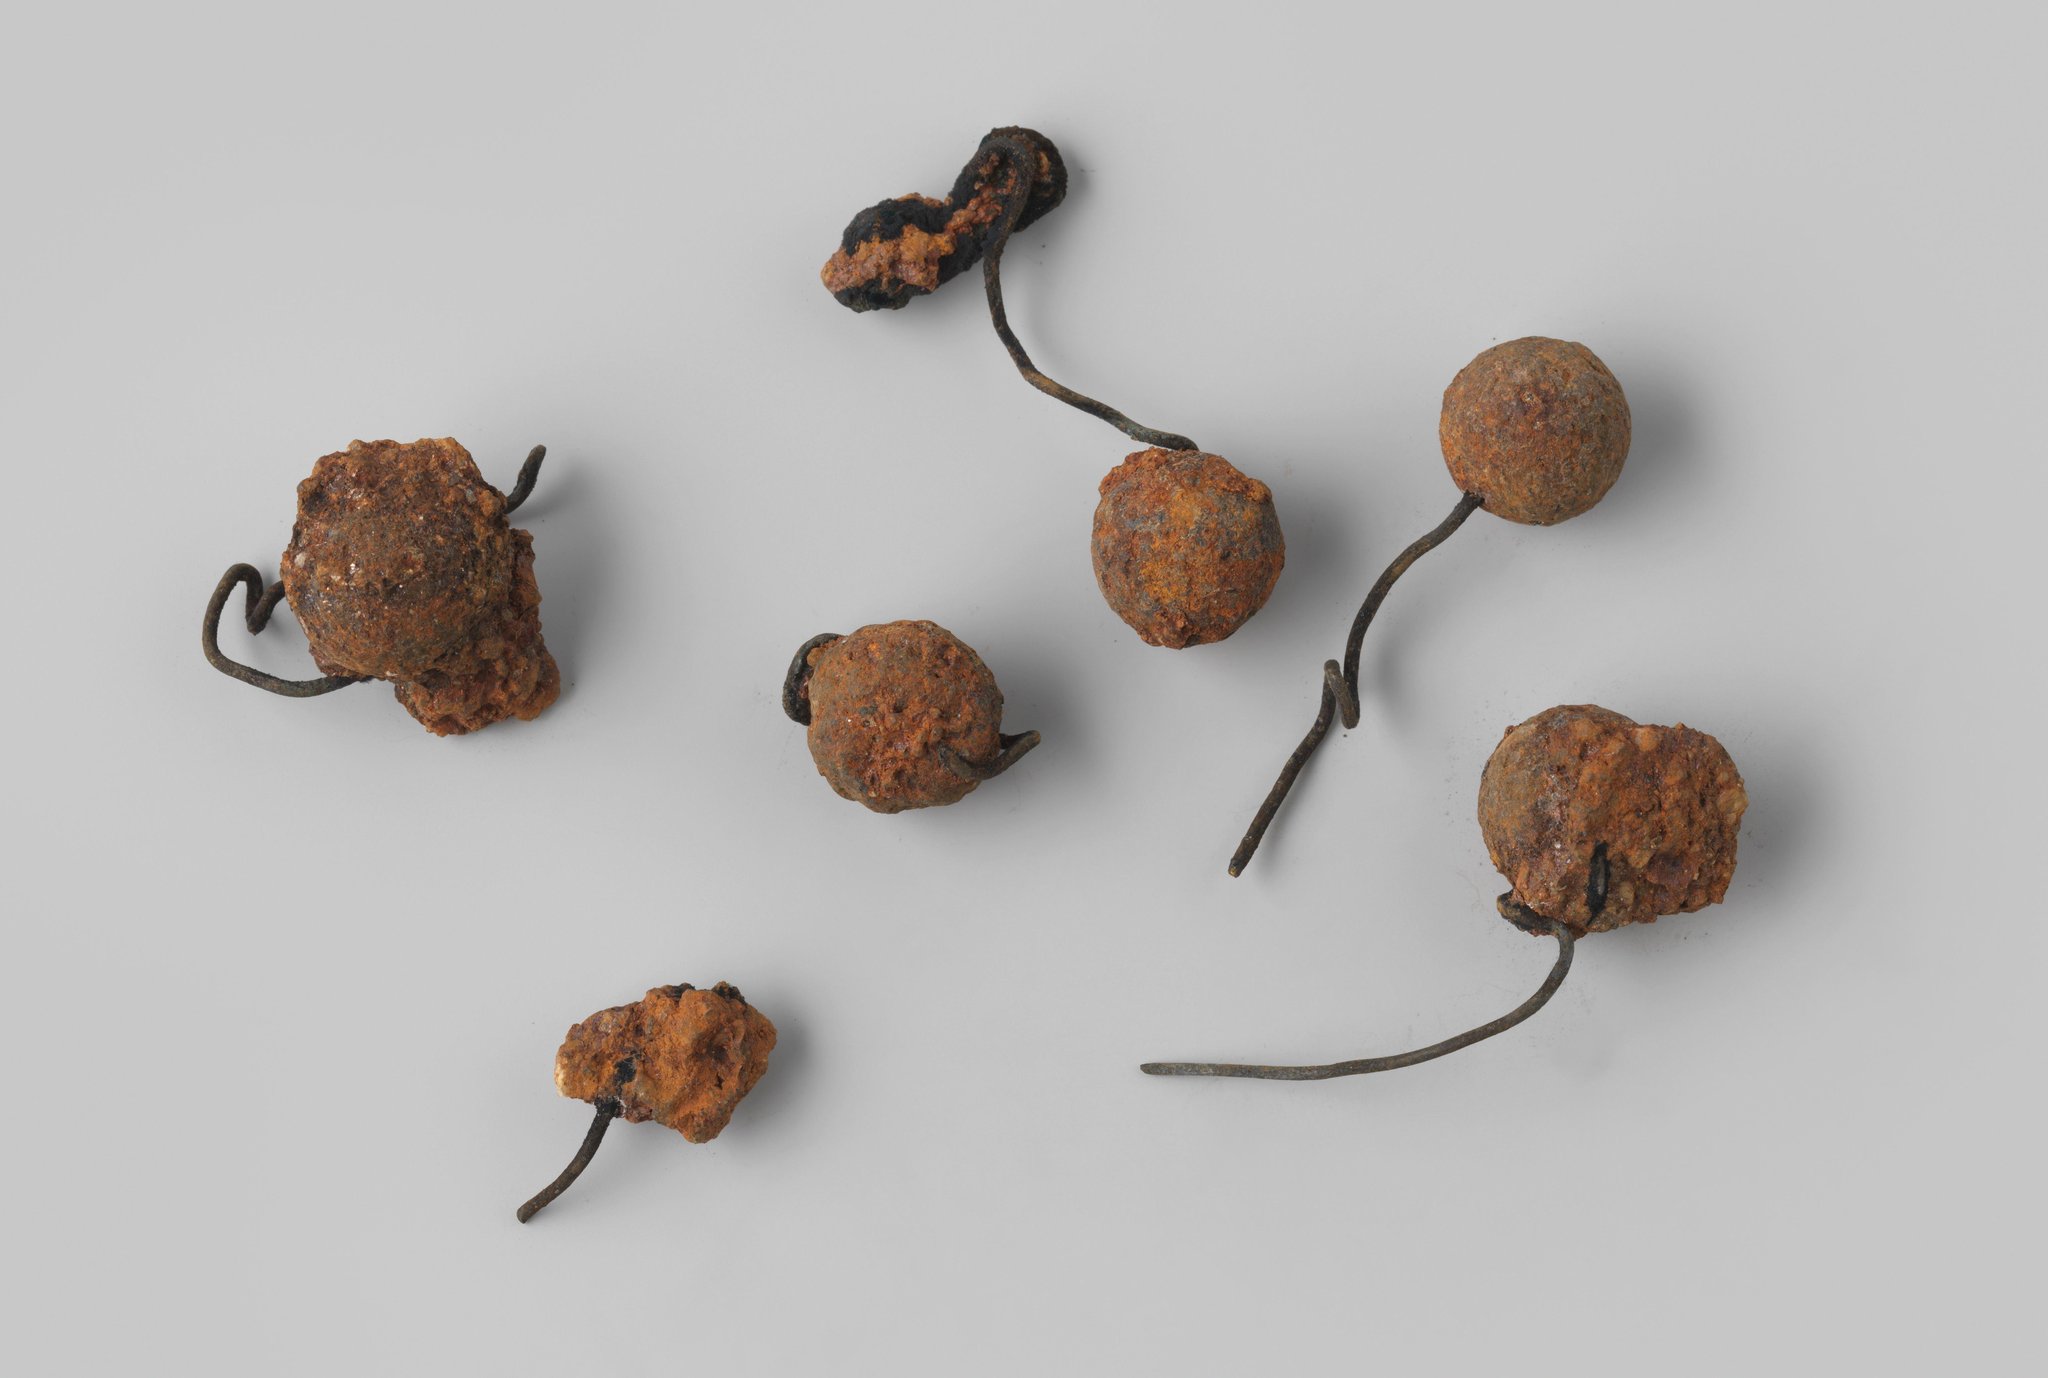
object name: chain shot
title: Kettingkogels uit het wrak van de Oost-Indiëvaarder Hollandia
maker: Anonymous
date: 1700-1743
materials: lead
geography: netherlands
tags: verenigde oostindische compagnie, hollandia (schip), annet